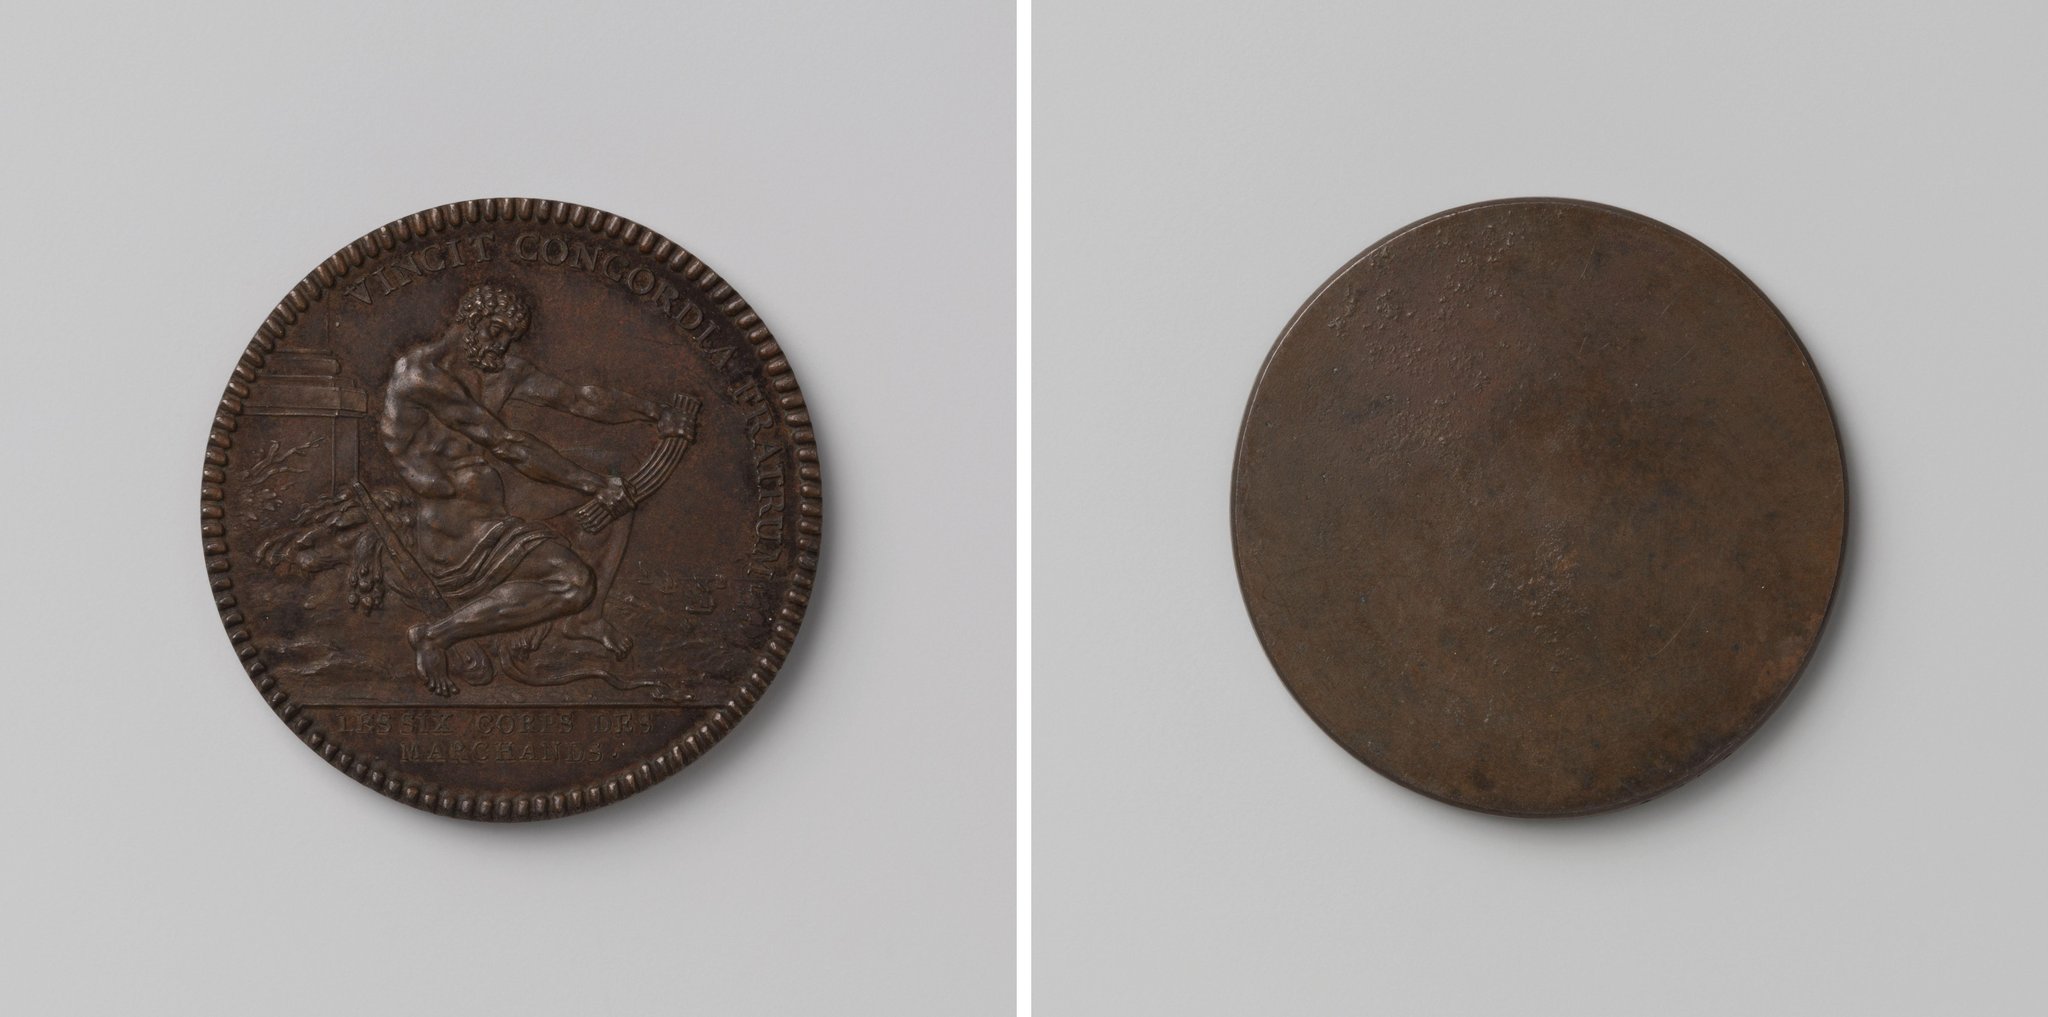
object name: jeton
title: Overwinning op de Triple Alliantie, penning geslagen op last van 'Les Six Corps des Marchands'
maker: Anonymous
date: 1672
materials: copper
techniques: striking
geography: france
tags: netherlands, paris, rampjaar (disaster year)